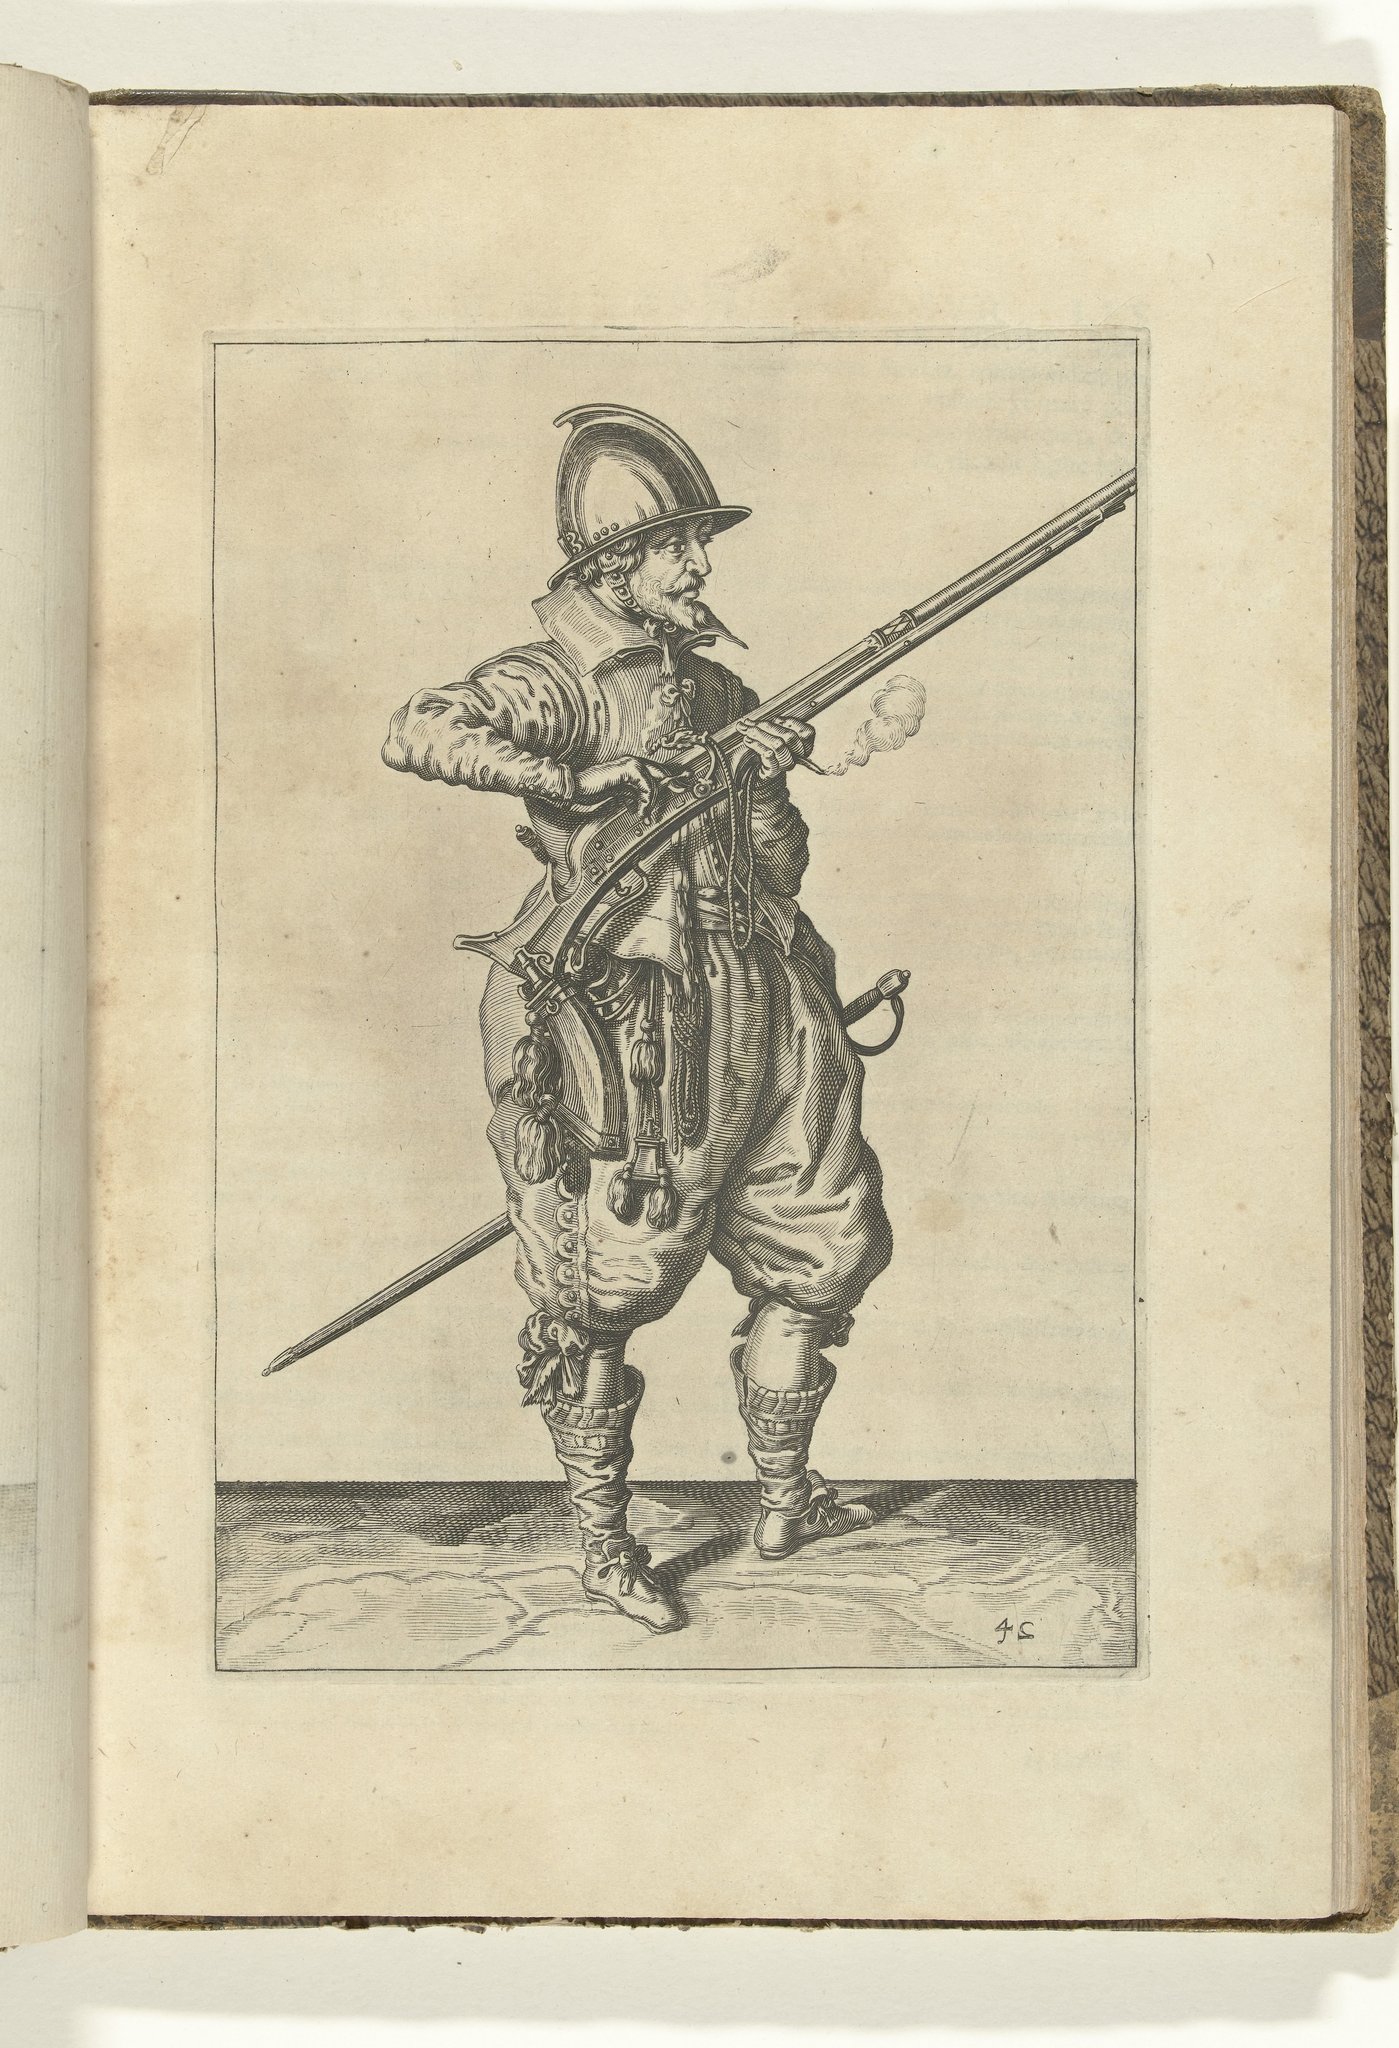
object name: print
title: Soldaat op wacht die de pan van zijn roer met twee vingers bedekt tegen vonken (nr. 42), ca. 1600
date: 1597-1608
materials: paper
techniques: engraving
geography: northern netherlands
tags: maurice (prince of orange), handling of weapons ~ military training, weapons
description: Een soldaat op wacht, ten voeten uit, naar rechts, die een roer (een bepaald type vuurwapen) met zijn linkerhand vasthoudt (nr. 42), ca. 1600. Op de haan (onderdeel van het ontstekingsmechanisme) van zijn roer ligt de brandende lont. Met de wijsvinger en de middelvinger van zijn rechterhand bedekt hij de pan (het kruitreservoir) van zijn roer om het kruit te beschermen tegen vonken van de lont. Plaat 42 in de instructies voor het hanteren van de roer: Brief enseignement, sur la representation des figures, du droit maniement de l'Harquebuse. Onderdeel van de illustraties in een Franse editie van J. de Gheyns Wapenhandelinghe: J. de Gheyn, Maniement d'armes, d'arquebuses, mousquetz et piques : en conformité de l'ordre de Mour le Prince Maurice, Prince d'Orange, Amsterdam 1608. Krijgswezen rond 1600.